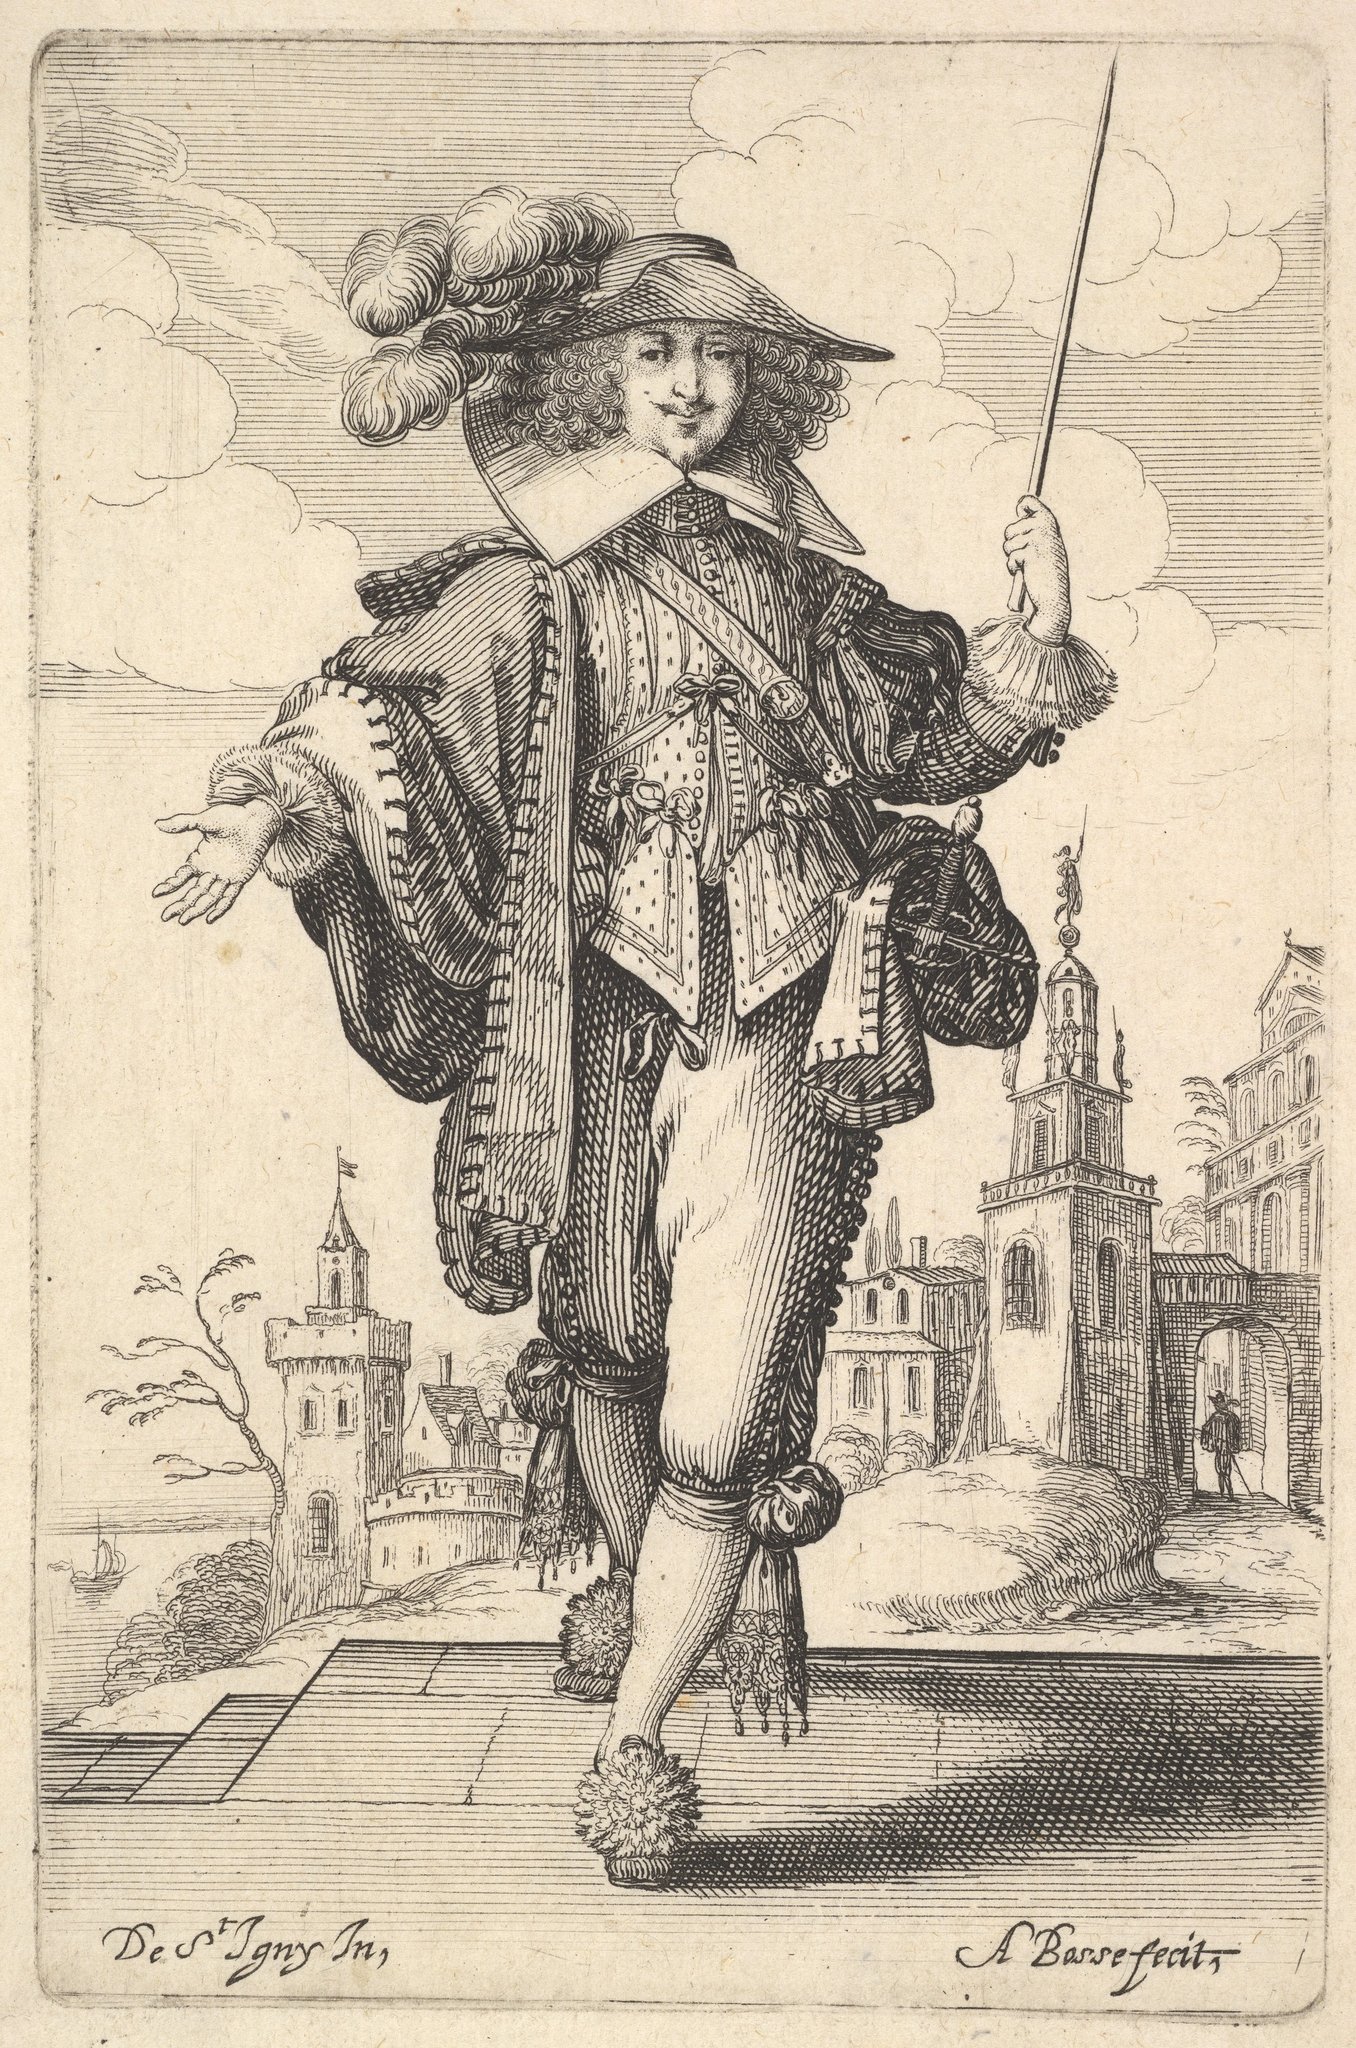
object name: print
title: A gentleman walking forward, with his right arm outstretched and a whip in his left hand, wearing a plumed hat and decorated shoes, from "The Garden of the French Nobles In Which One Can Pick Up Their Way of Dressing"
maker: abraham bosse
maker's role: artist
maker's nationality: french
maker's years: 1602-1676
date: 1629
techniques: etching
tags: men,walking